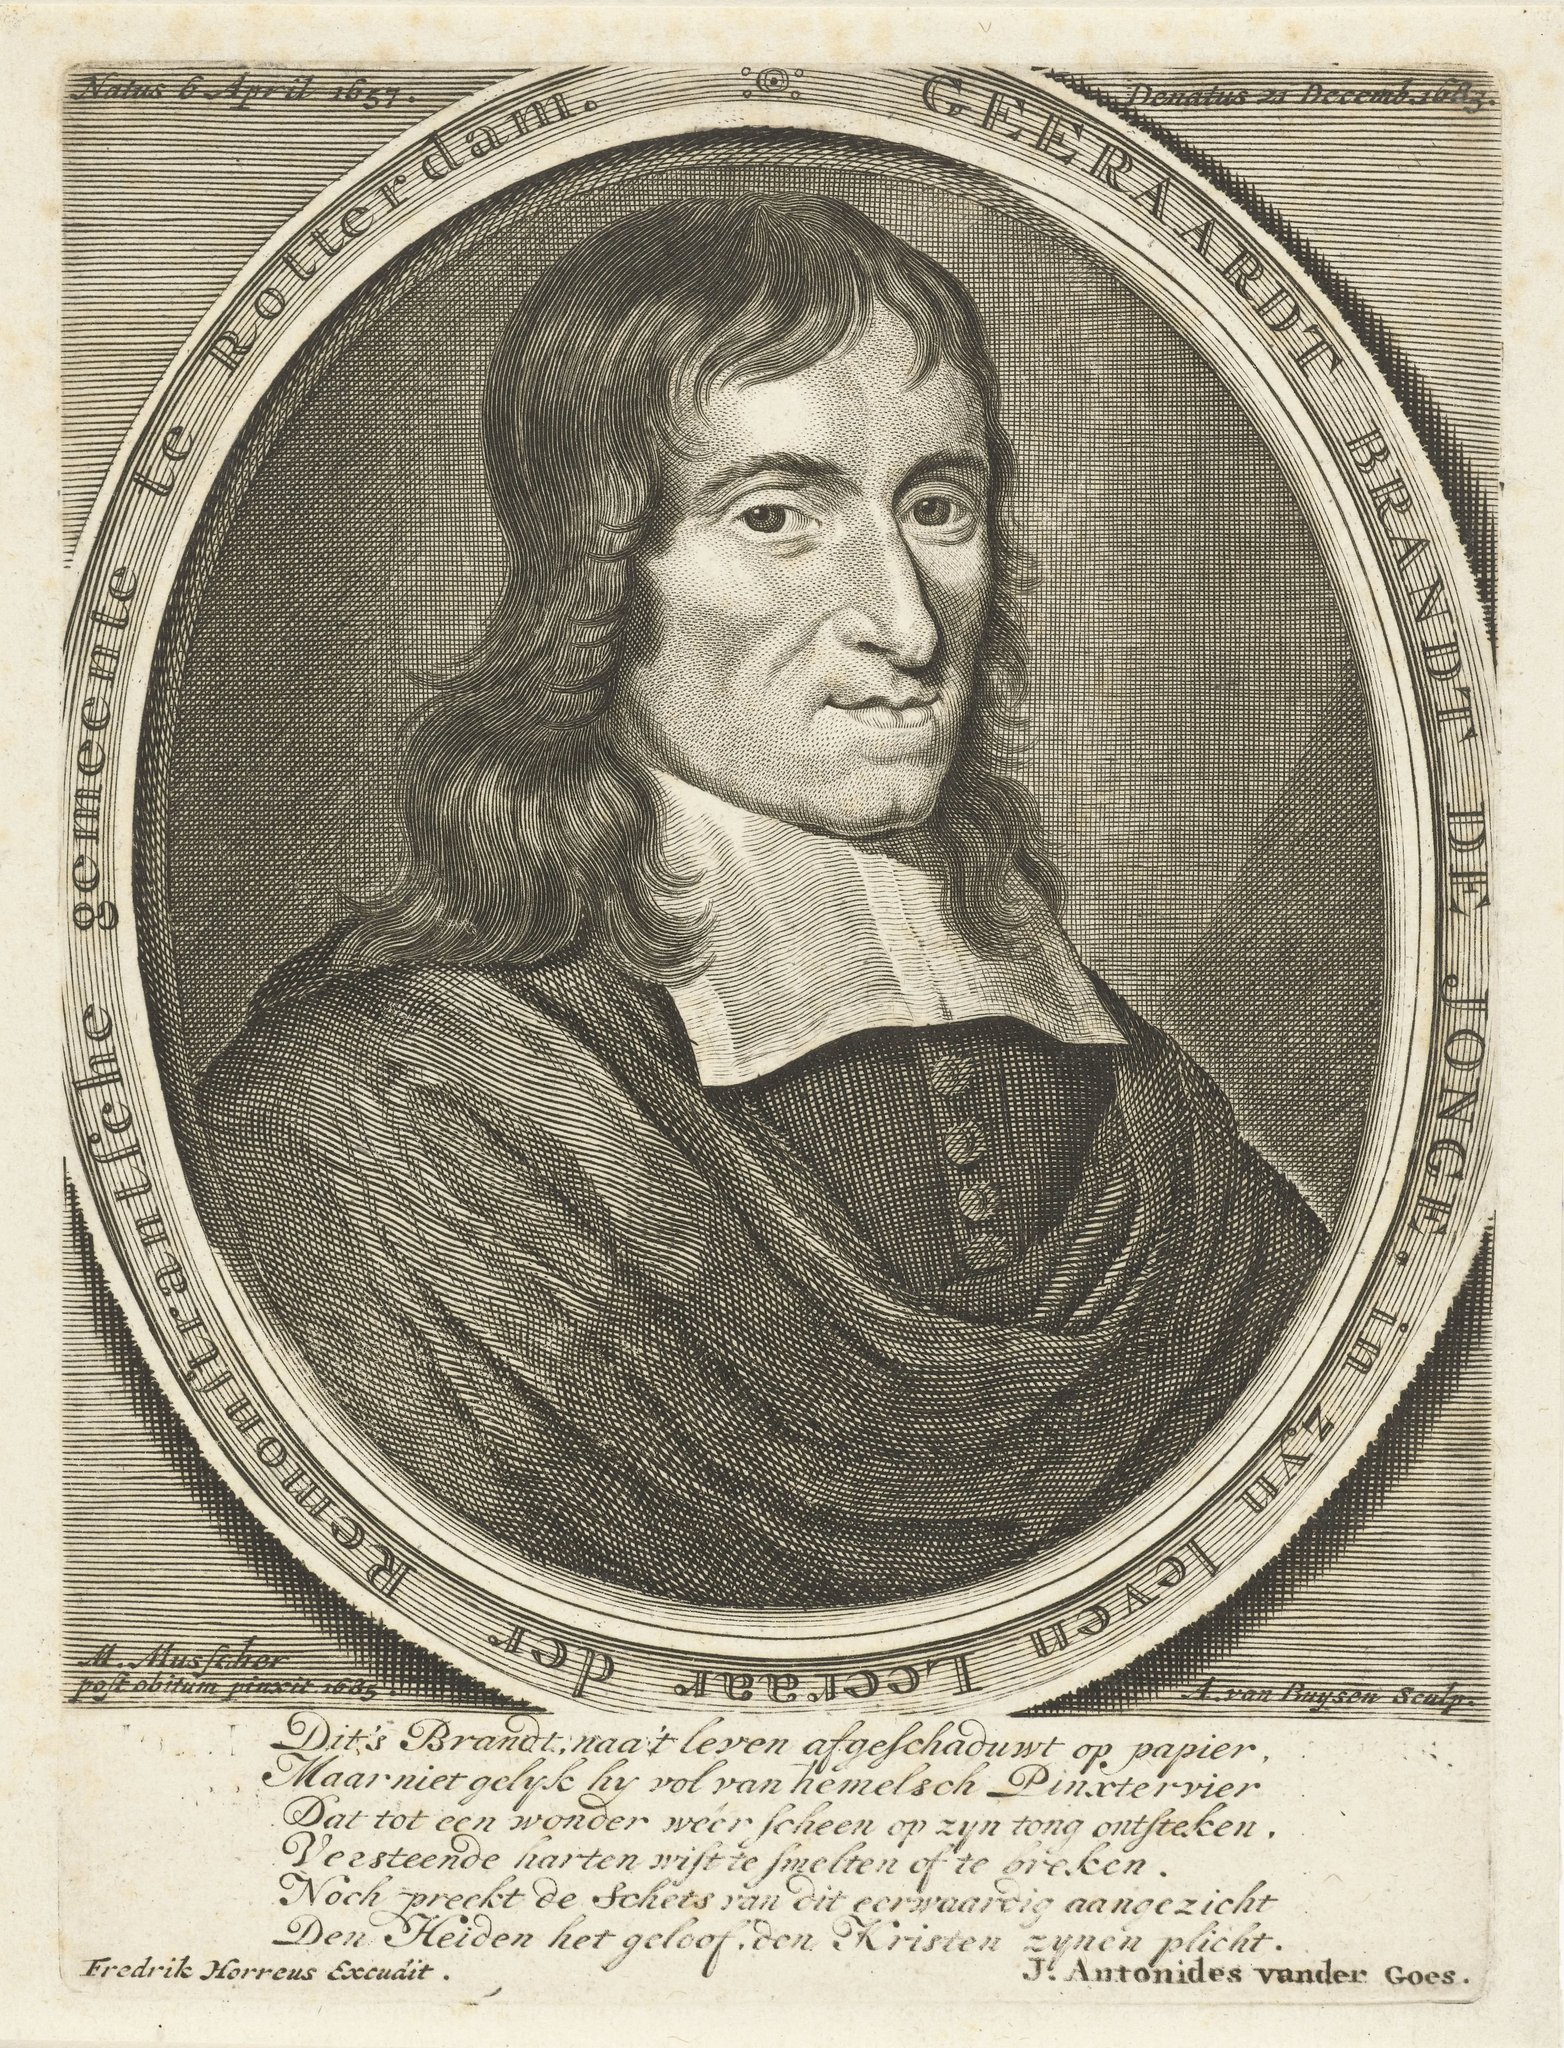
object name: print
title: Portret van Gerard Brandt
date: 1720-1730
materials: paper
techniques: engraving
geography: amsterdam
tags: rotterdam, portrait of a writer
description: Portretbuste van Gerard Brandt, in ovaal met randschrift. Onder het portret een lofdicht van Jan Antonides van der Goes.